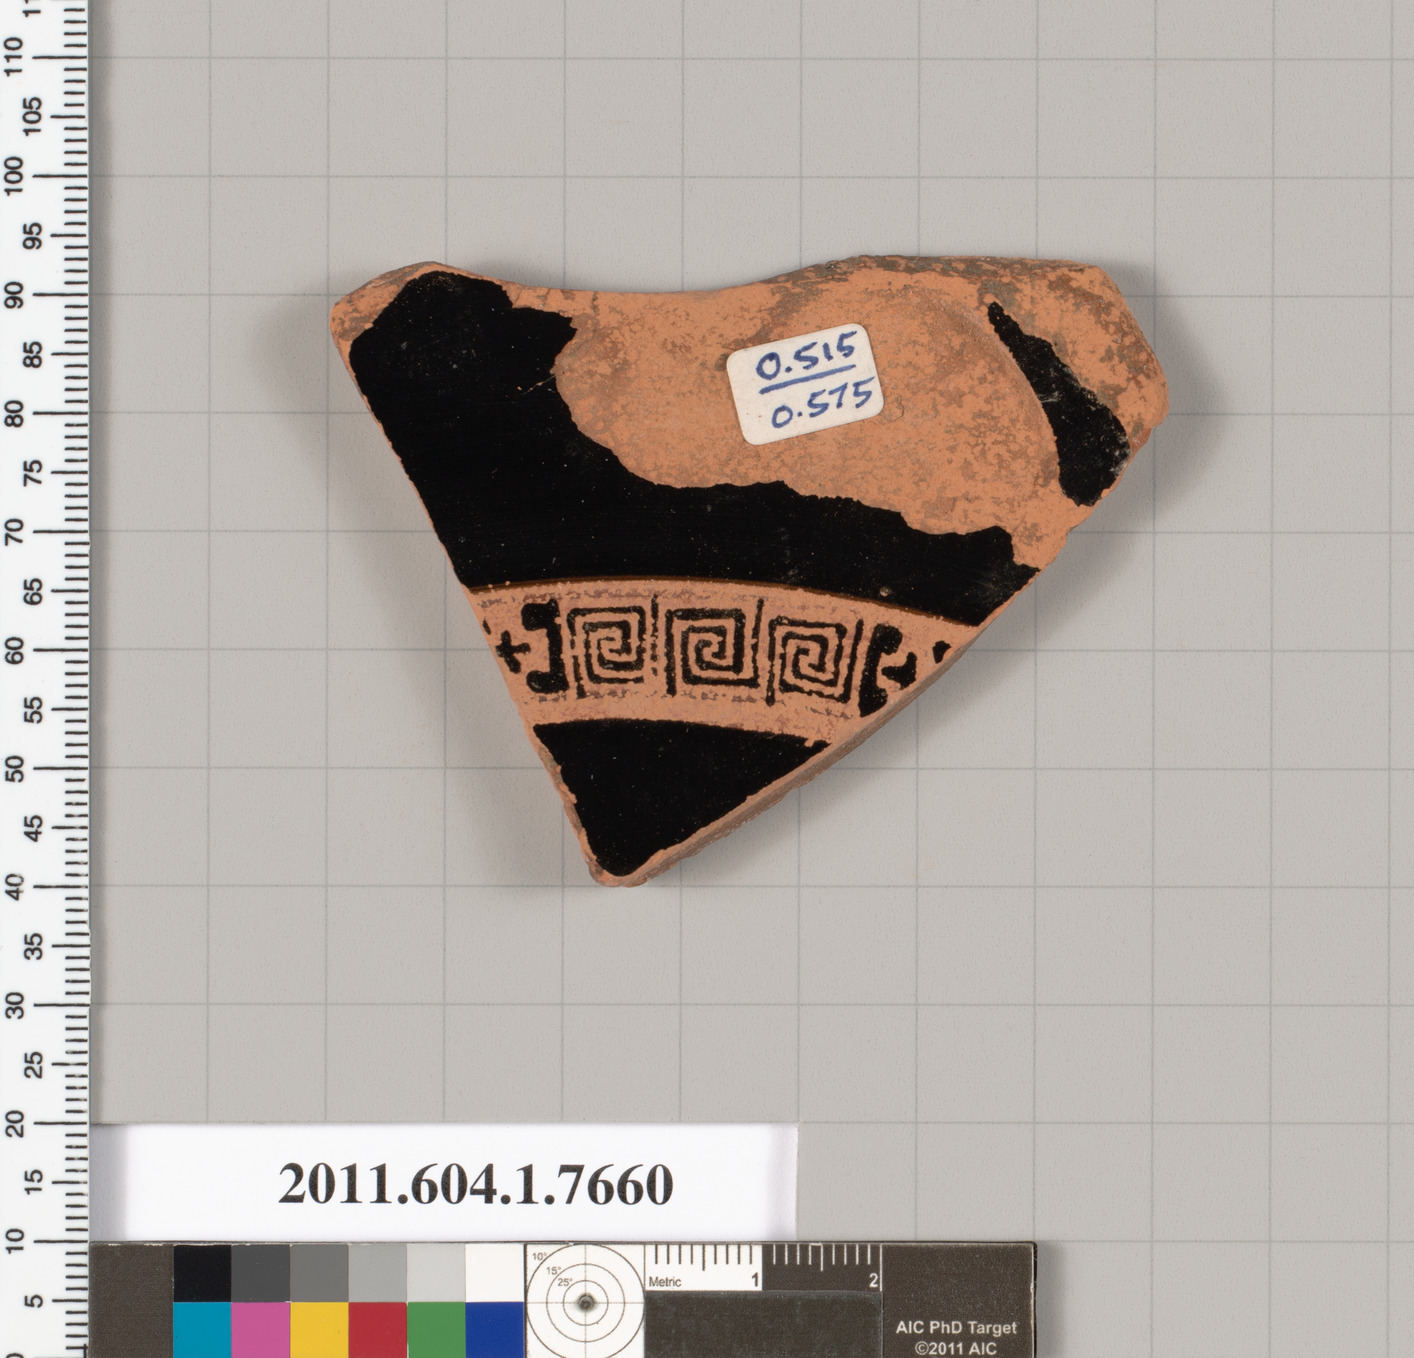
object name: kylix fragment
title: Terracotta fragment of a kylix (drinking cup)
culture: greek, attic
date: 460-450 BCE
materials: terracotta